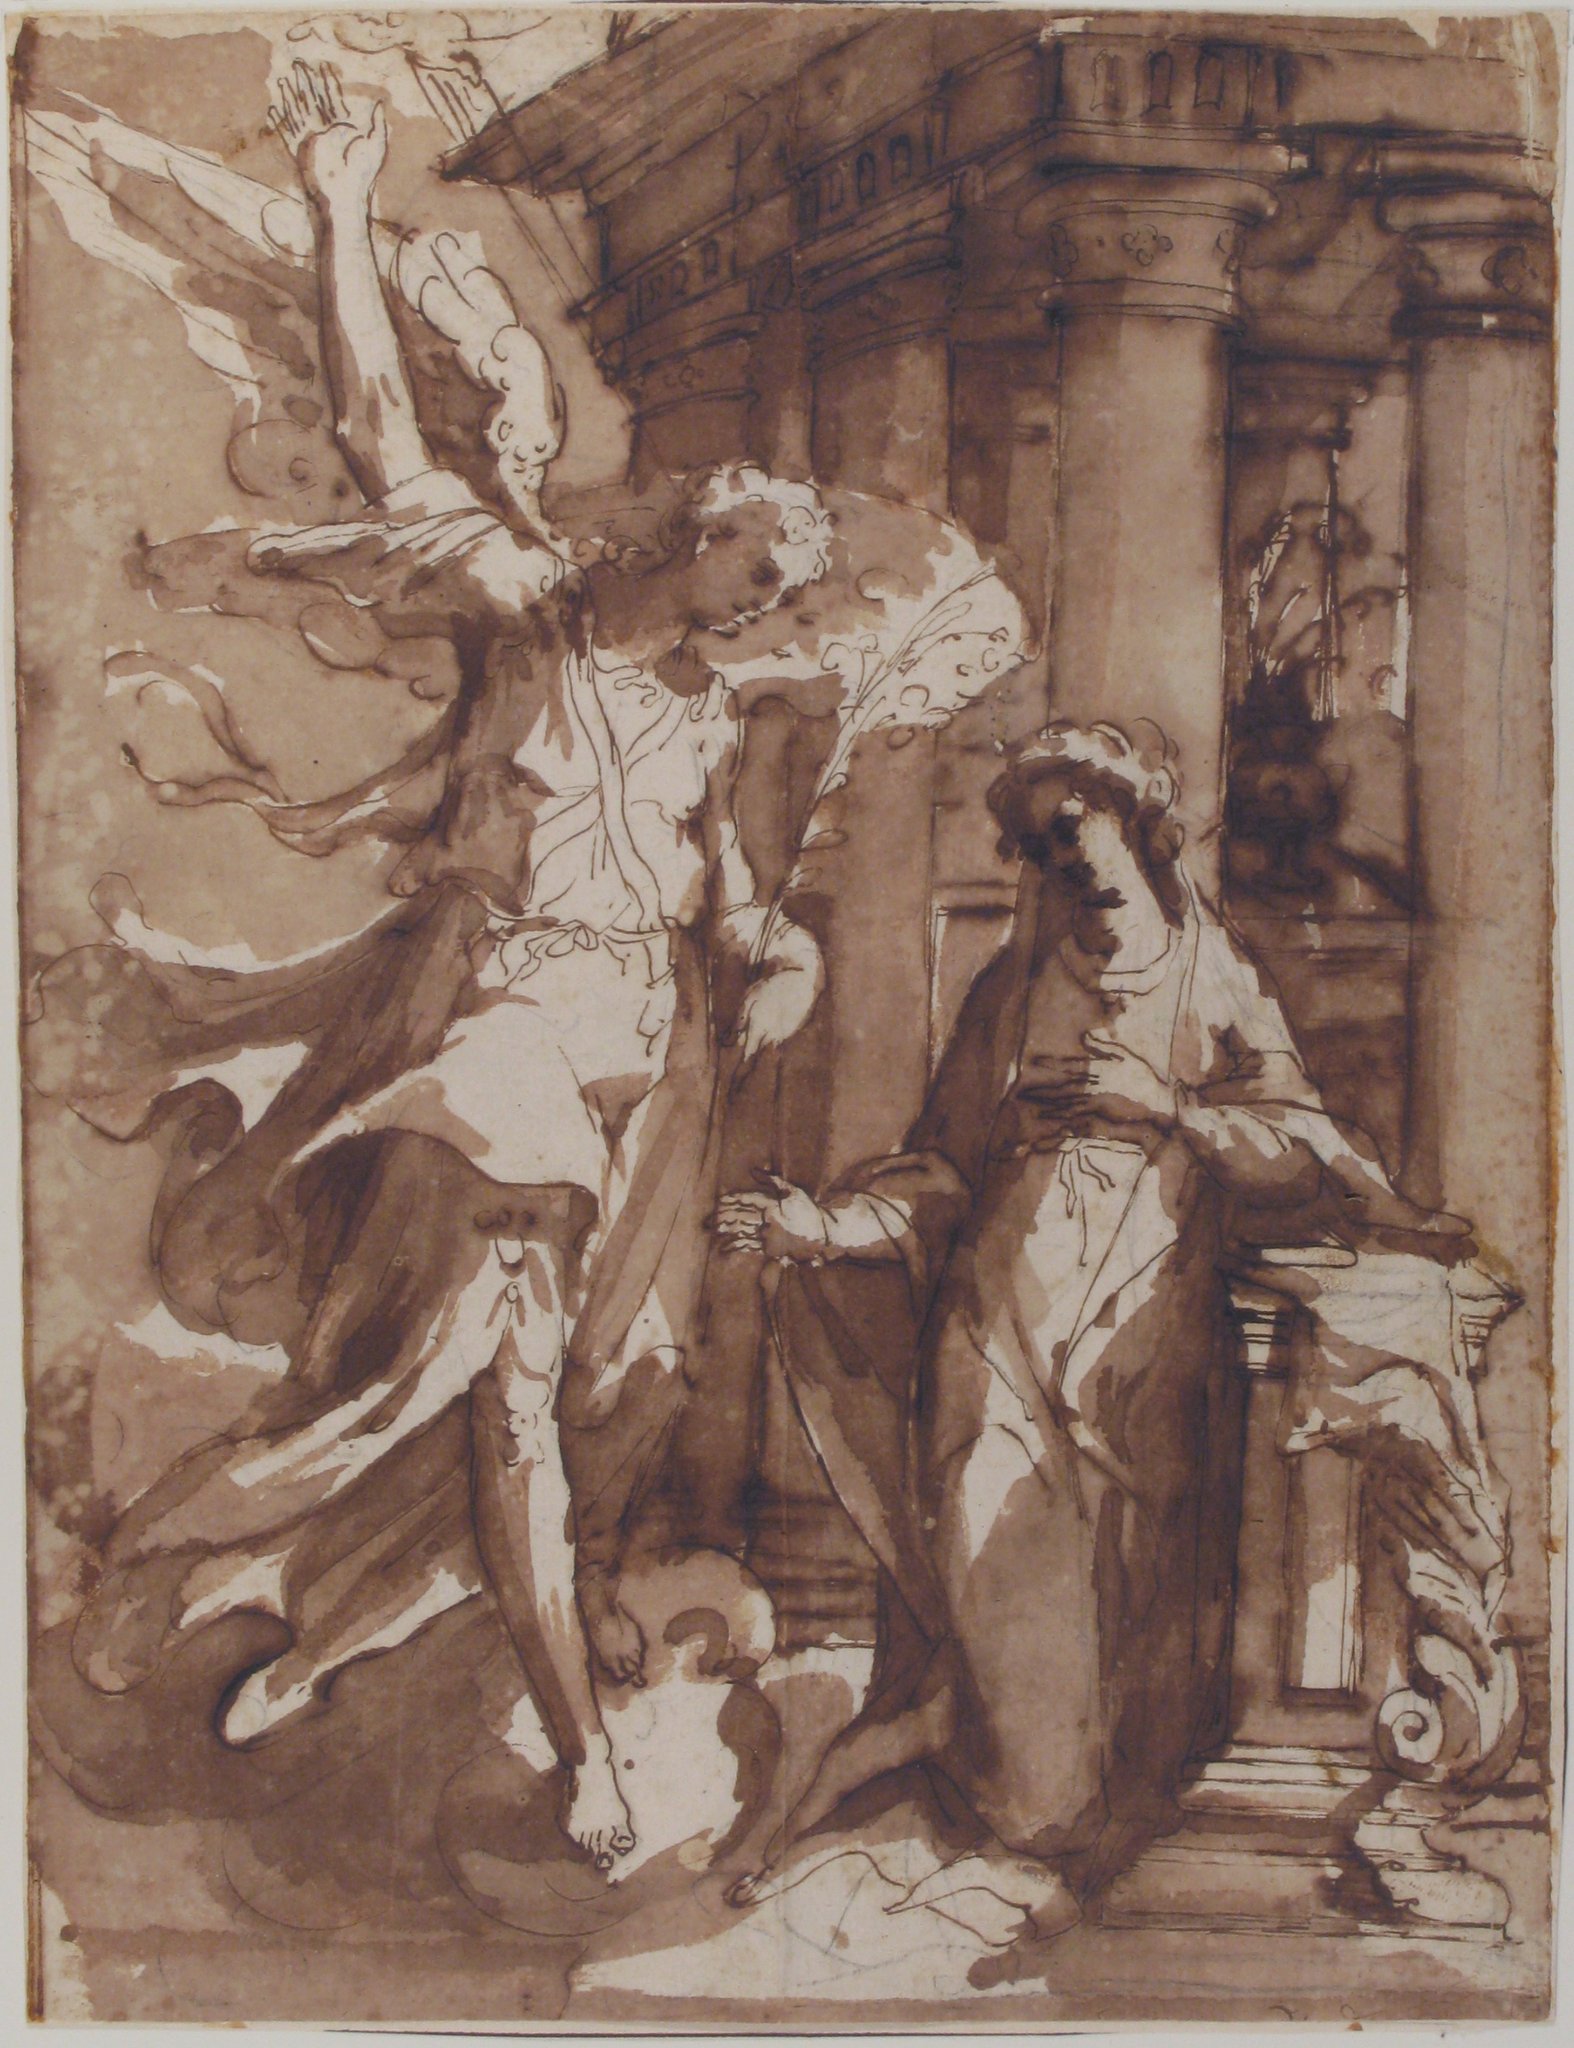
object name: drawing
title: The Annunciation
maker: francesco curia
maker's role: artist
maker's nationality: italian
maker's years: 1565-1608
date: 1565-1608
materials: chalk, ink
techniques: brush, pen, wash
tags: annunciation